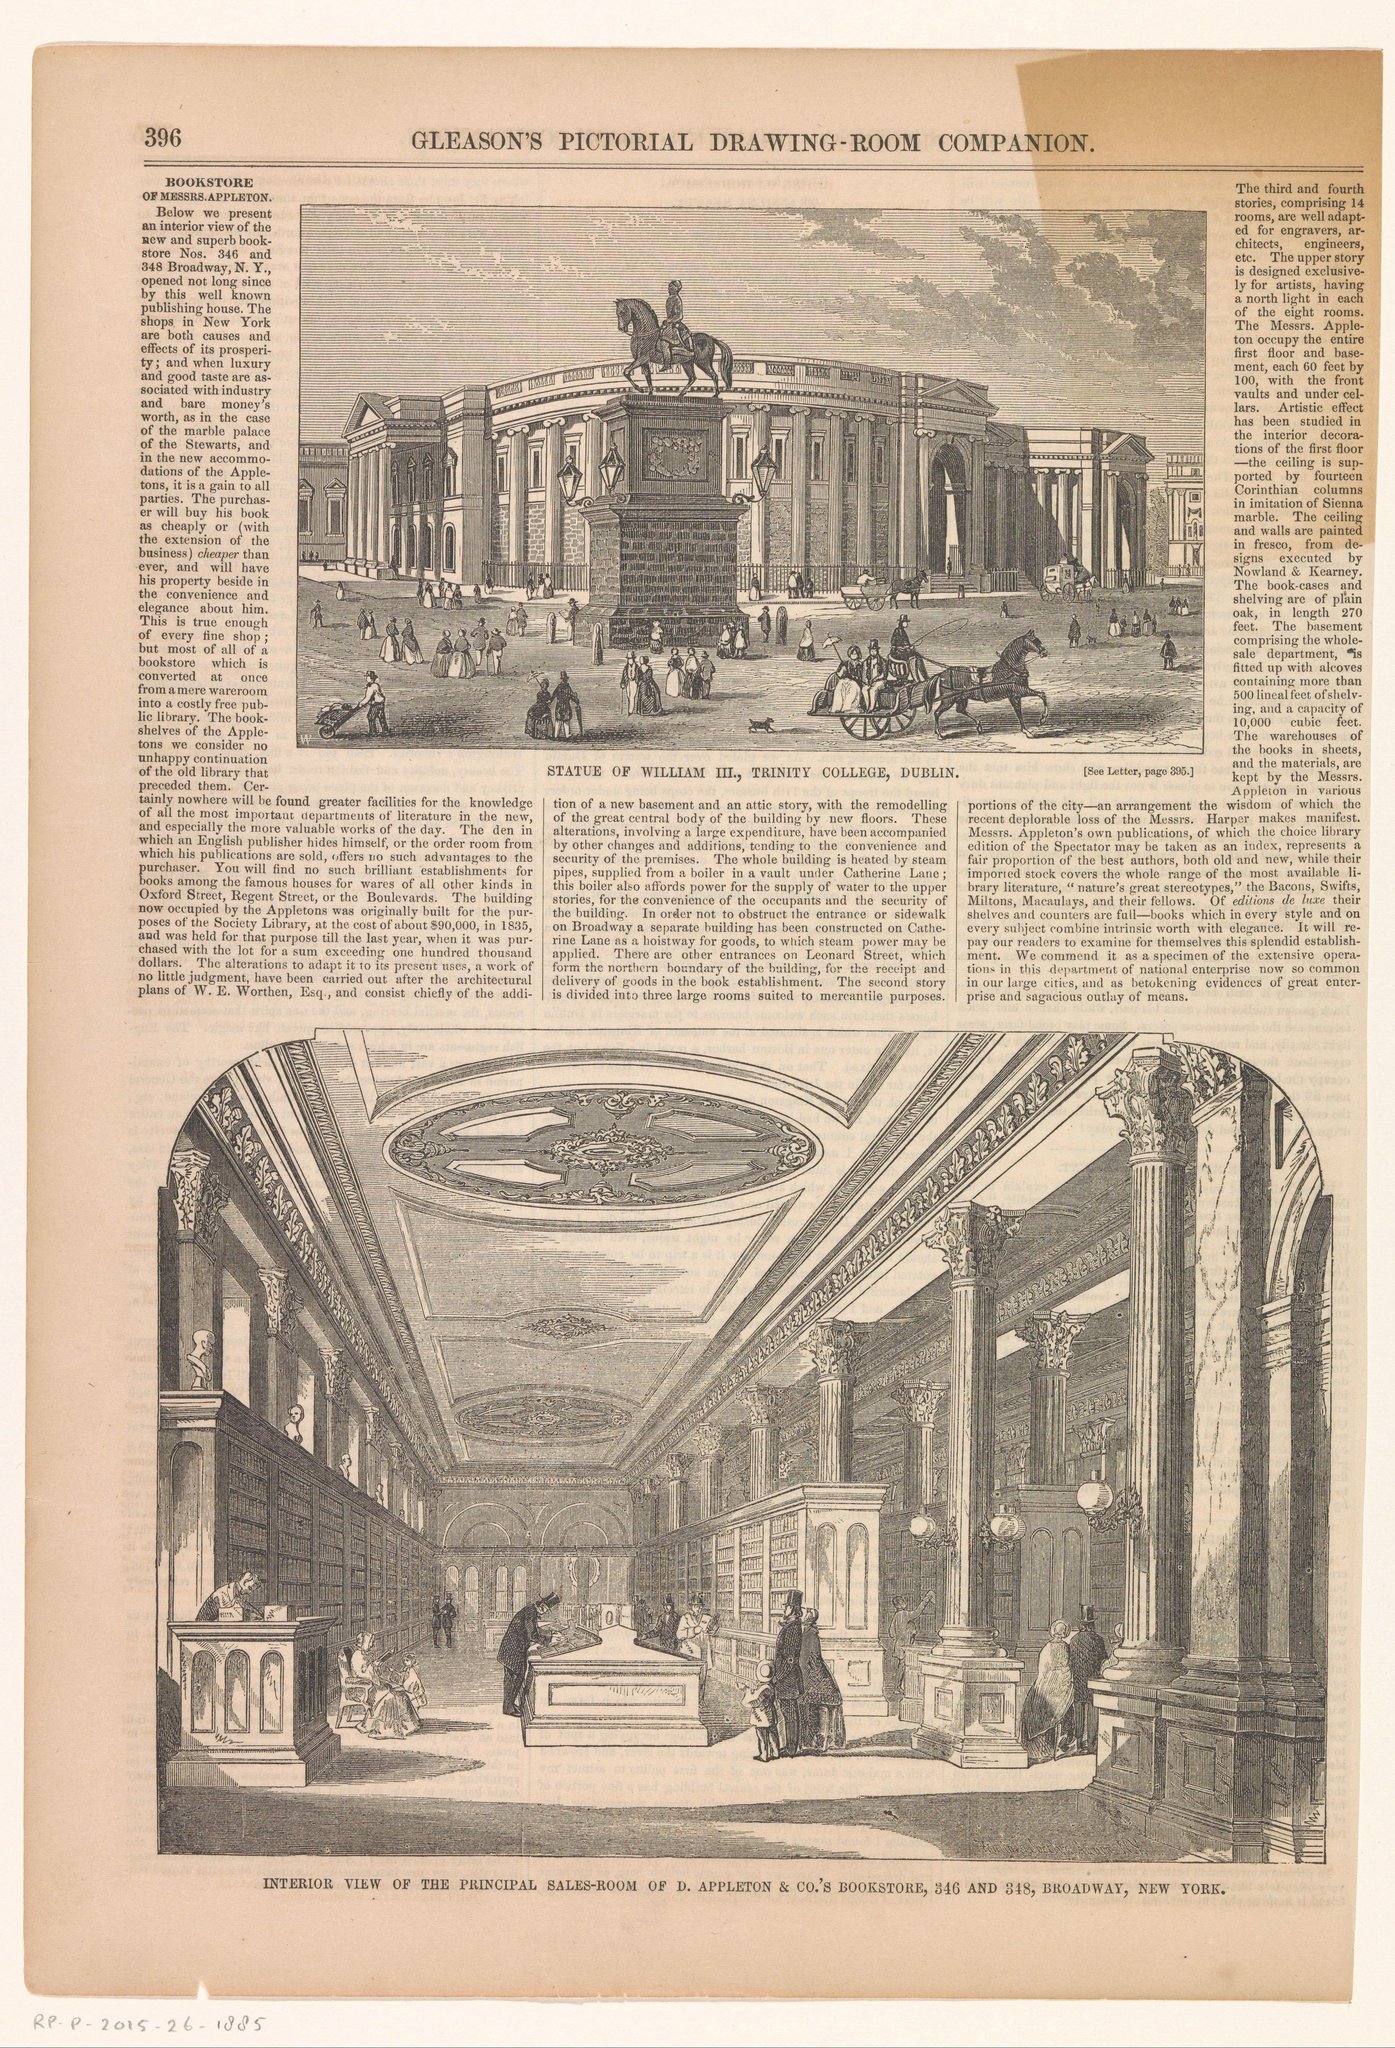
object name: print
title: Interieur van boekhandel D. Appleton & Co. te New York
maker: monogrammist w (prentmaker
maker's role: print maker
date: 1851-1854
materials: paper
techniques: engraving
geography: new york city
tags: the hague, william iii (prince of orange and king of england, scotland, and ireland), monument, statue, book-shop, bookseller, new york (city)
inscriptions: collector's mark: Lugt 2228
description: Twee illustraties op een blad. Boven het ruiterstandbeeld van Willem III, prins van Oranje, op het plein voor Trinity College te Dublin. Onder het interieur van boekhandel D. Appleton & Co. te New York. Linksboven genummerd: 396. Tekst op recto en verso.